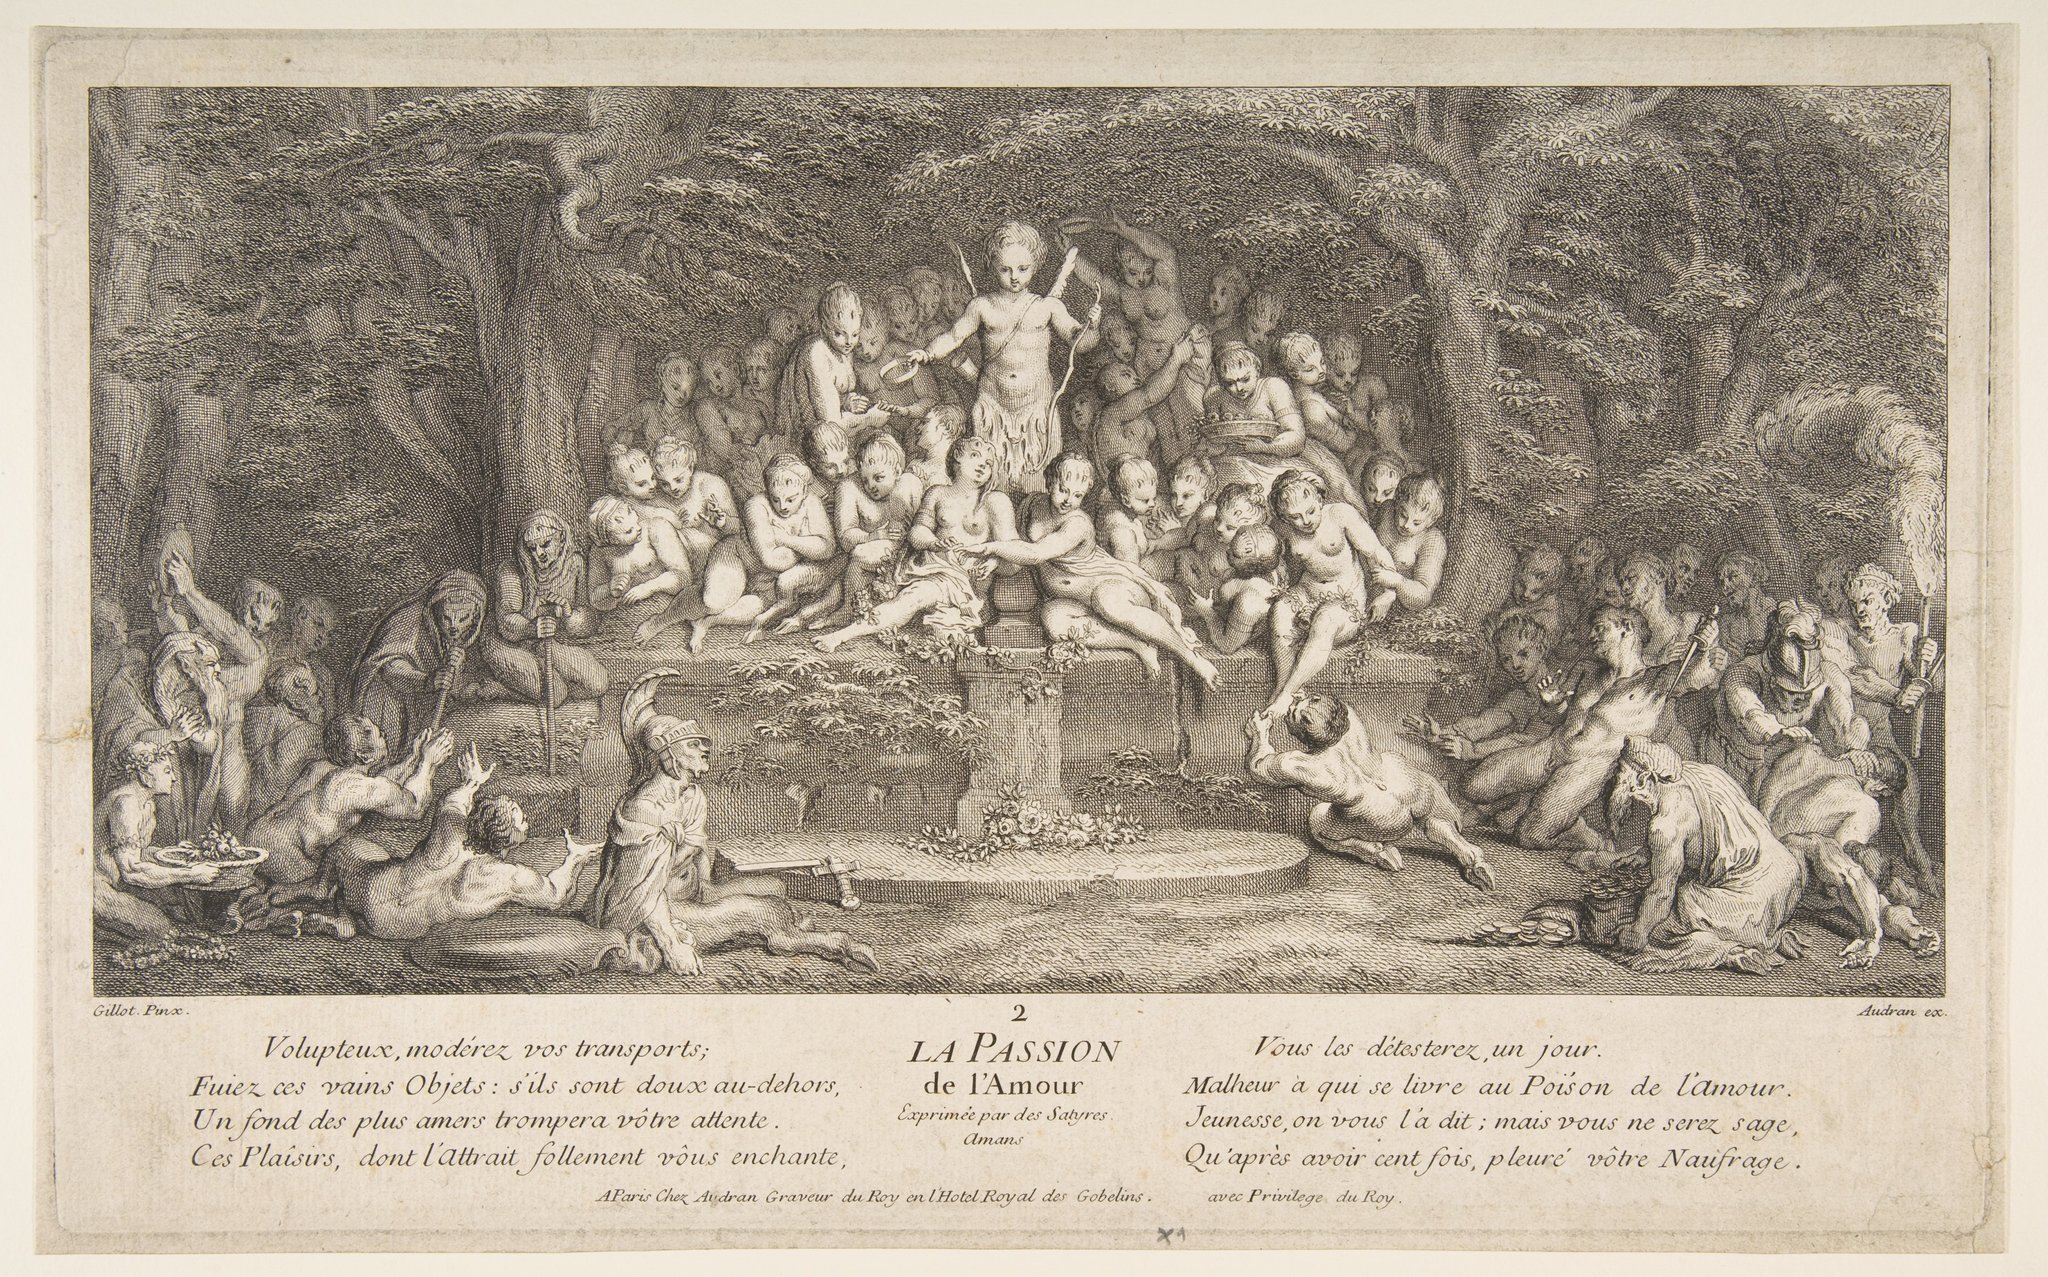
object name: print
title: The Passion for Love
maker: jean audran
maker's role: engraver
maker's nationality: french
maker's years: 1667-1756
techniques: etching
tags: love,male nudes,female nudes,cupid